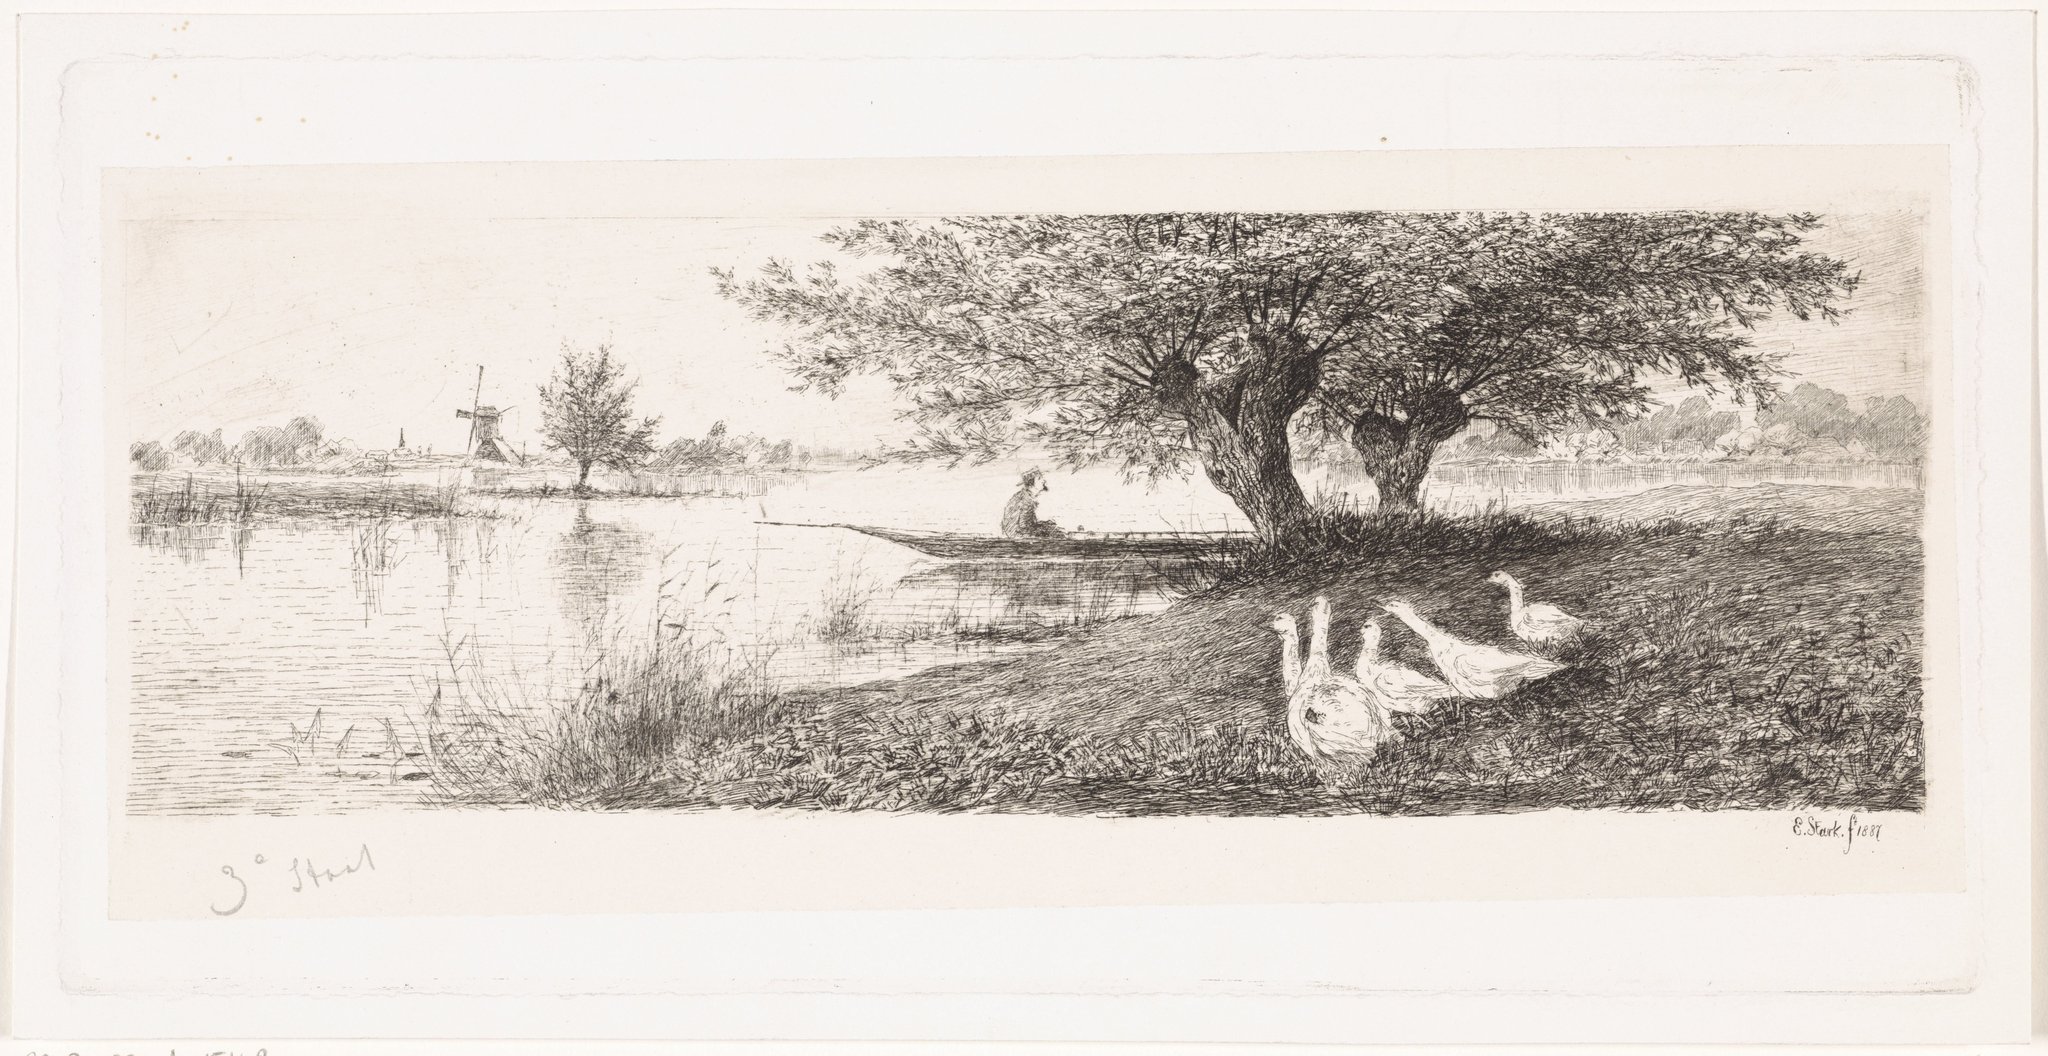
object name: print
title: Rivierlandschap met een man in een boot en ganzen op de oever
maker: elias stark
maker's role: draughtsman, print maker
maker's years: 1849-1933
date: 1887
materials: paper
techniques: etching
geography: nieuwer-amstel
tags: water-birds: goose, river, rowing-boat, canoe, etc., trees: willow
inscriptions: collector's mark: Lugt 2228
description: Op een rivier een man in een boot bij twee knotwilgen. Rechts op de oever ganzen. Links aan de horizon een molen.